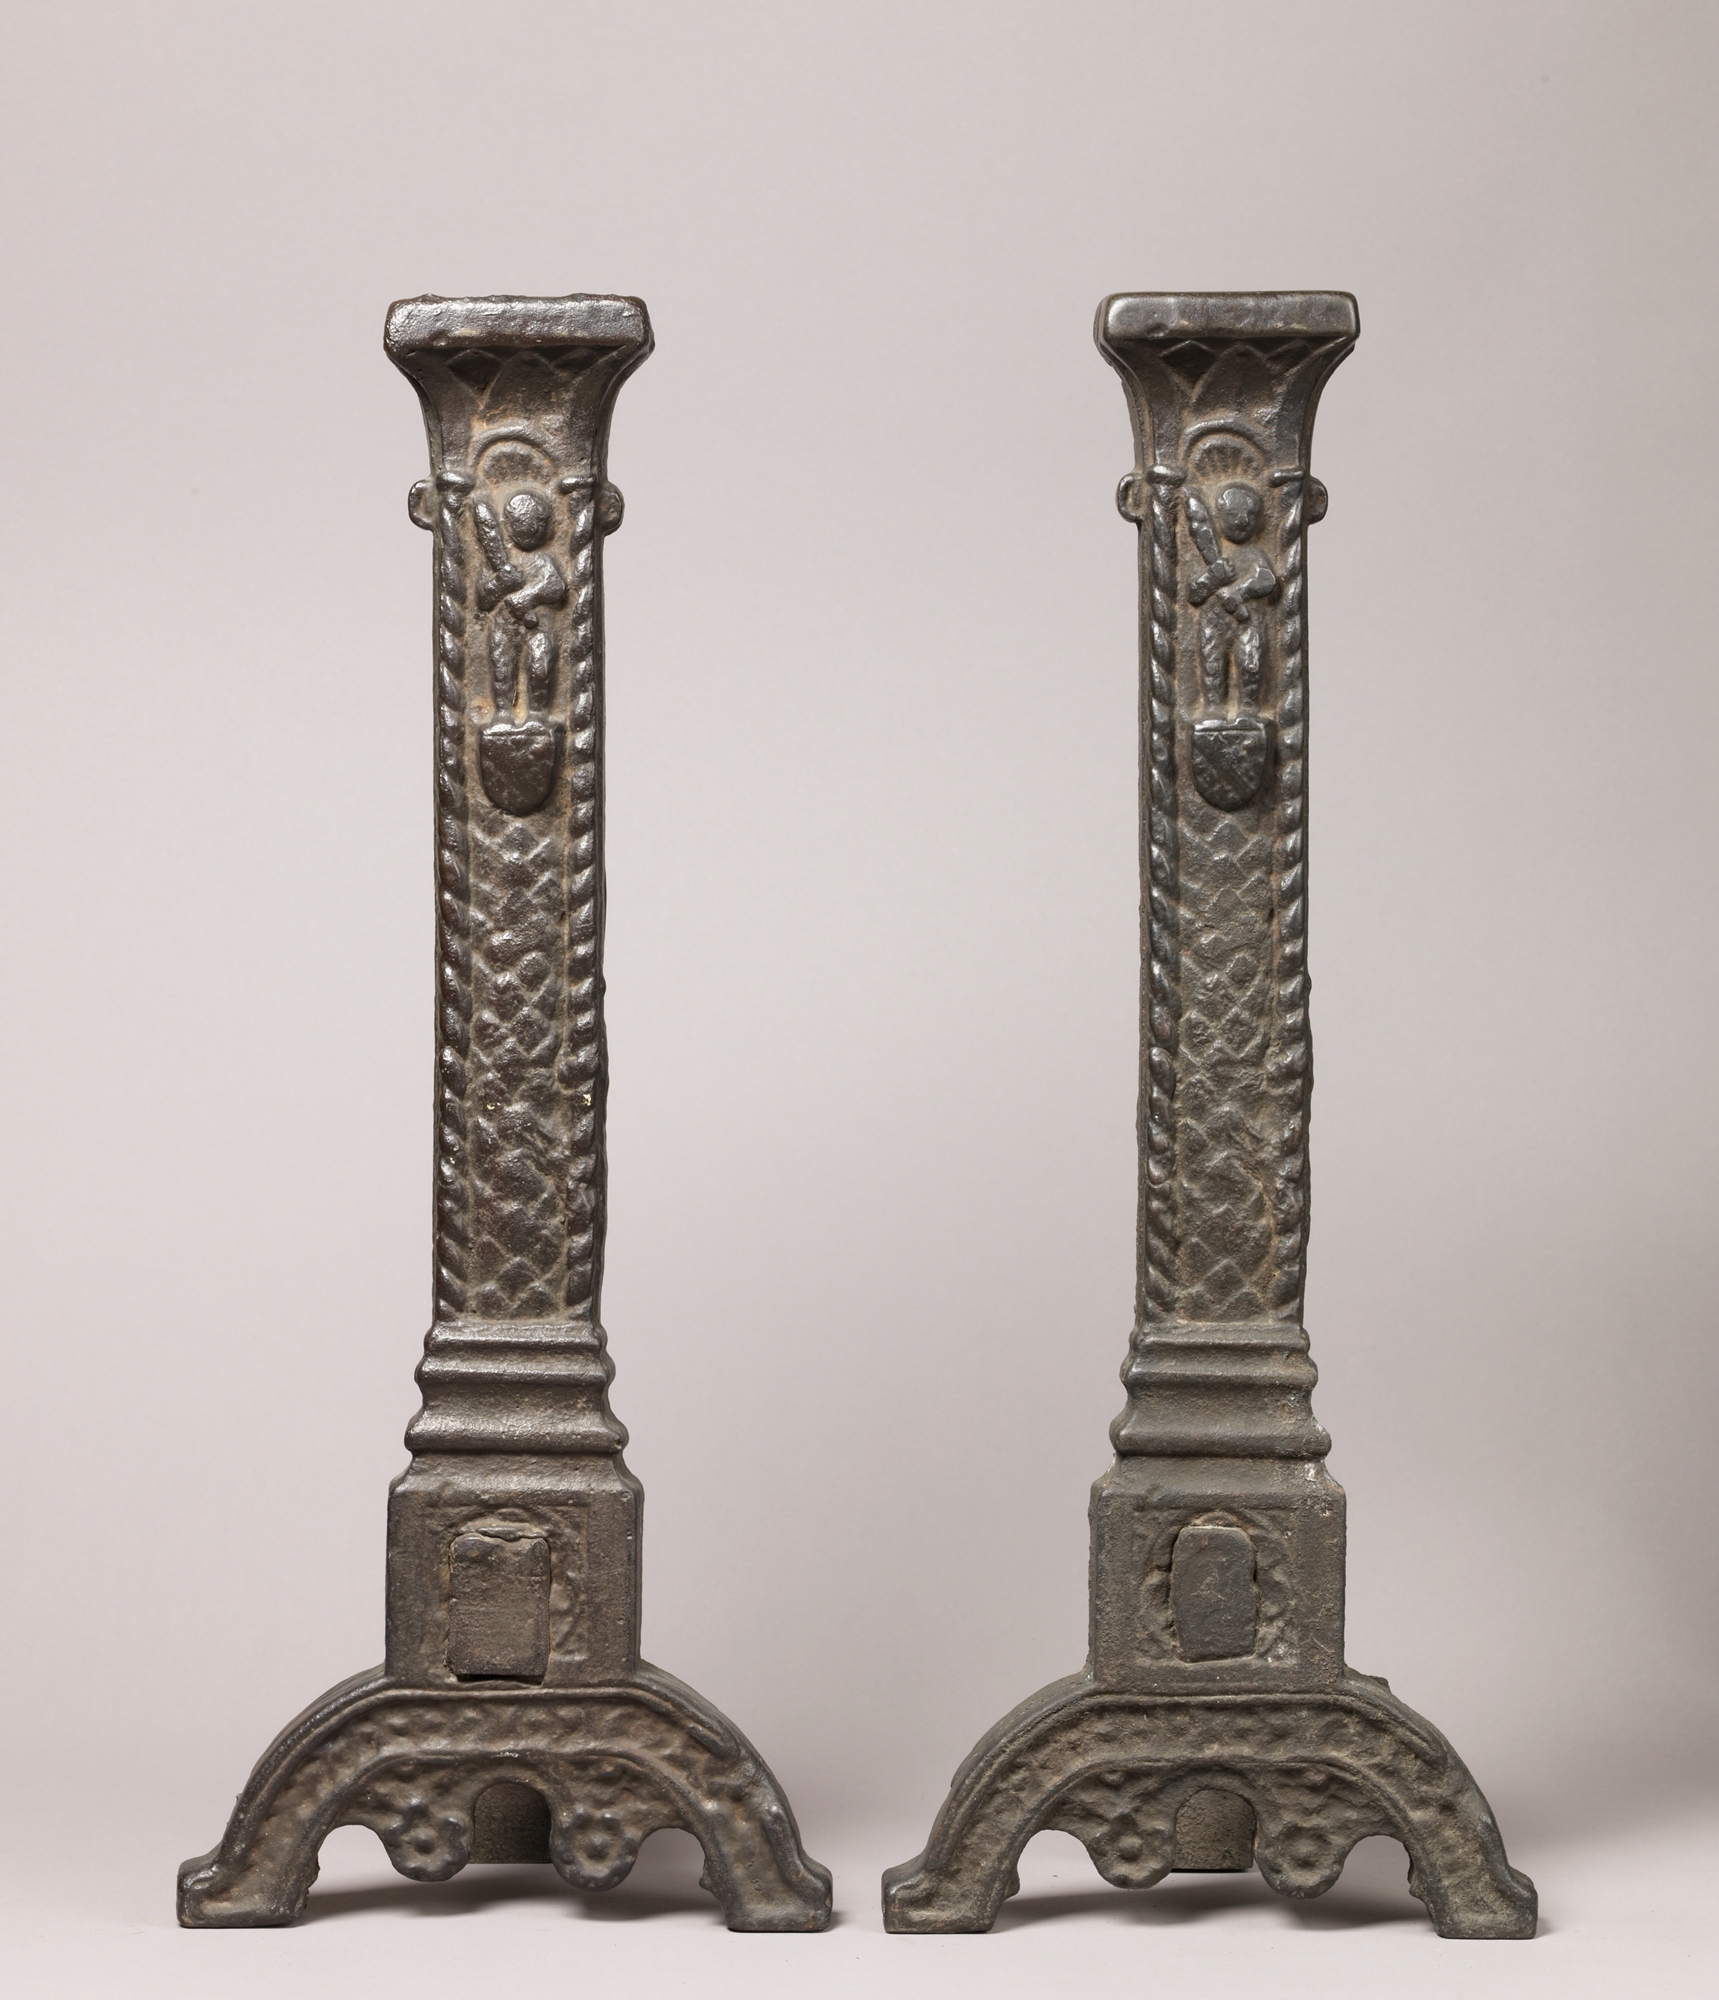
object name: firedog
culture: french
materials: iron